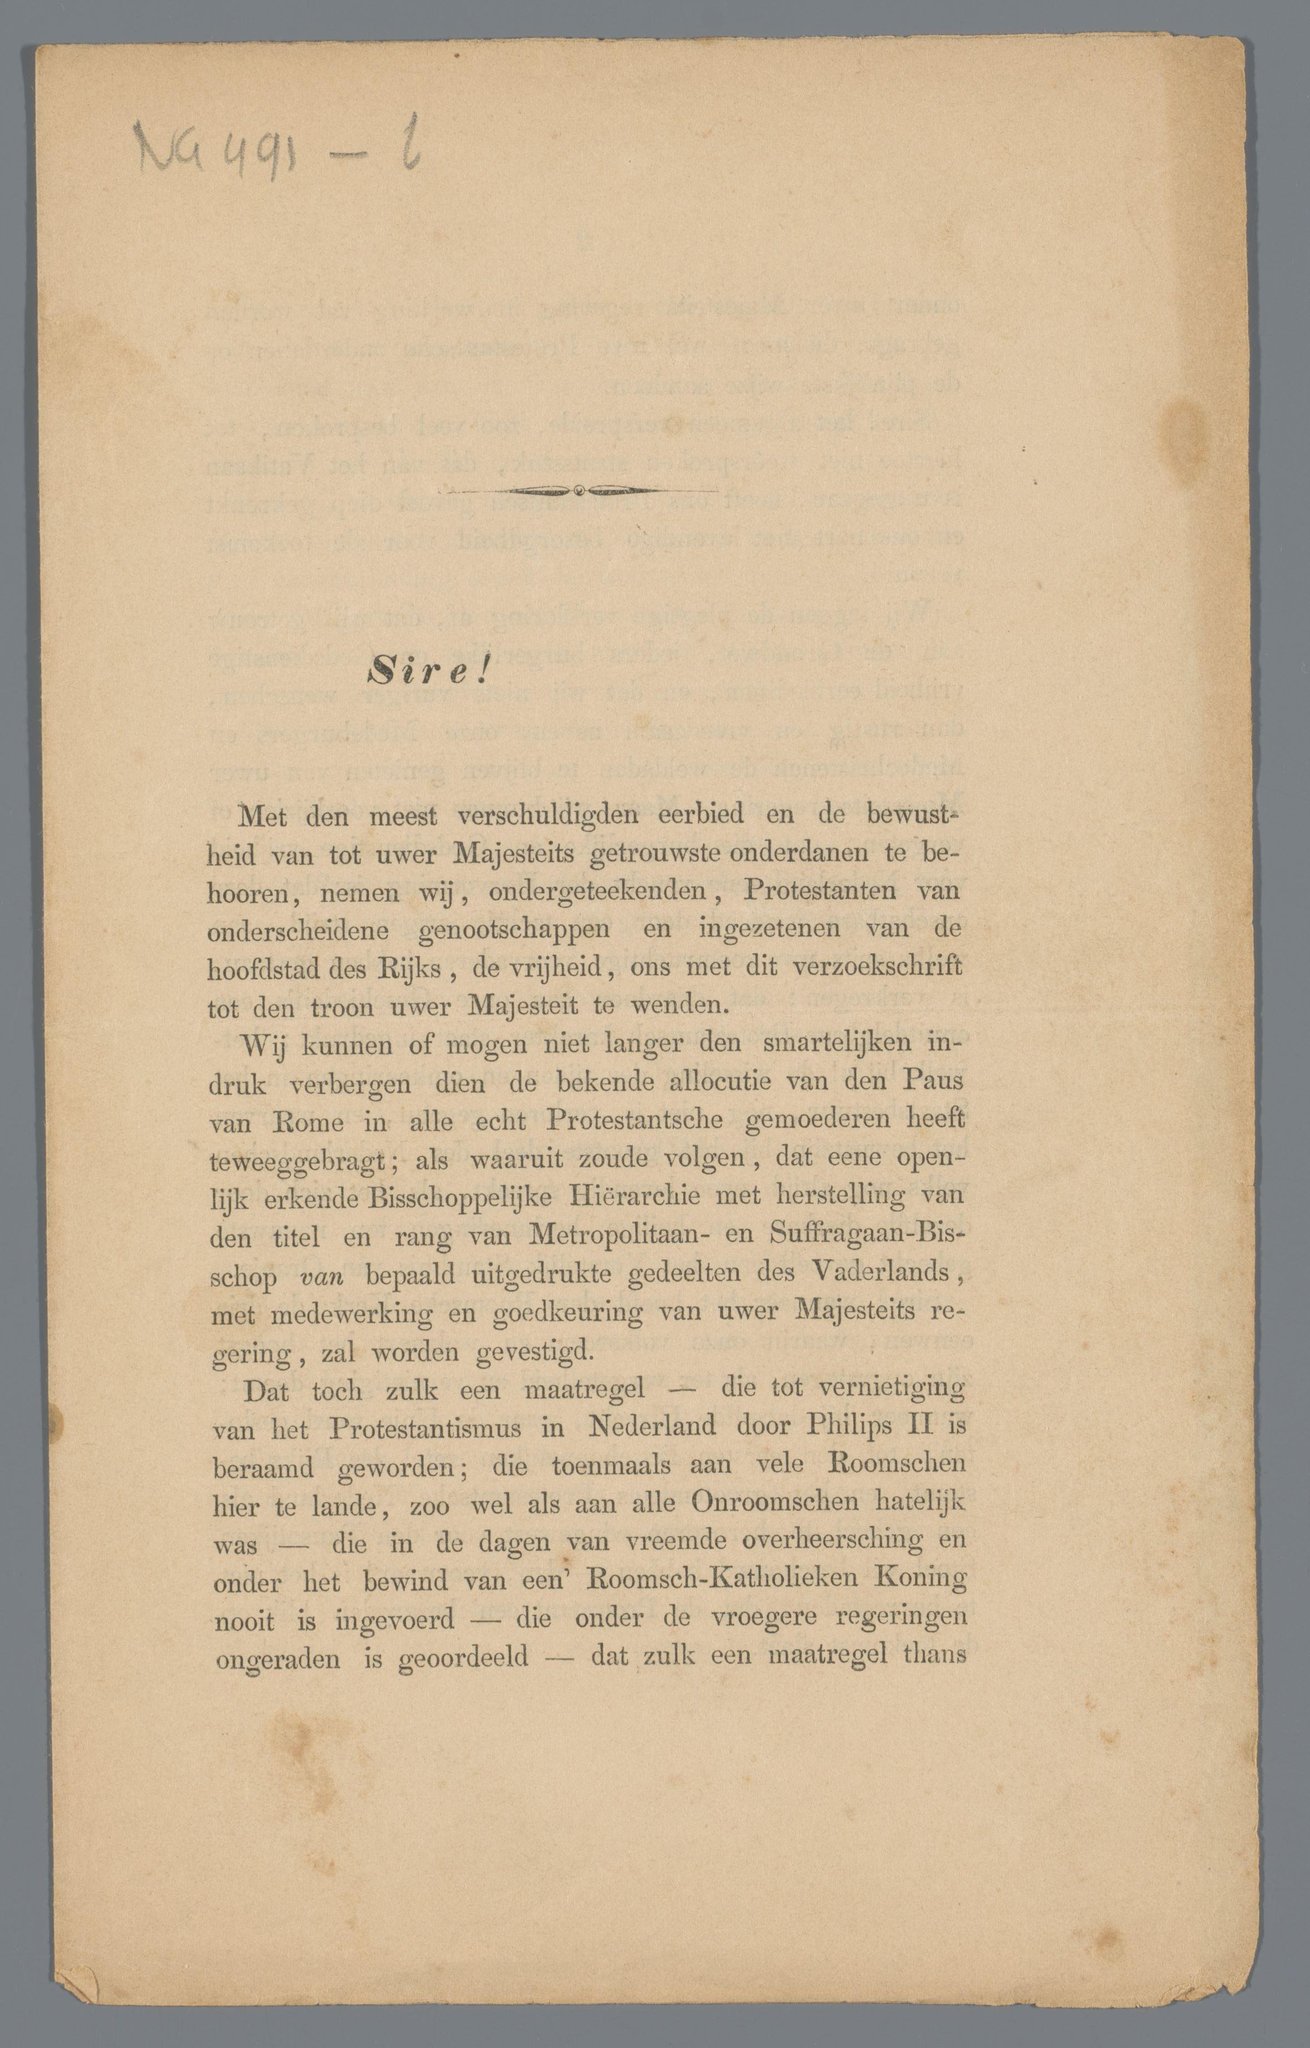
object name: pamphlet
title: Sire!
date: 1853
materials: paper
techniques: printing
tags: netherlands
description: Pamflet, vouwblad, 4 pp, adres aan koning Willem III. Van protestantse origine.